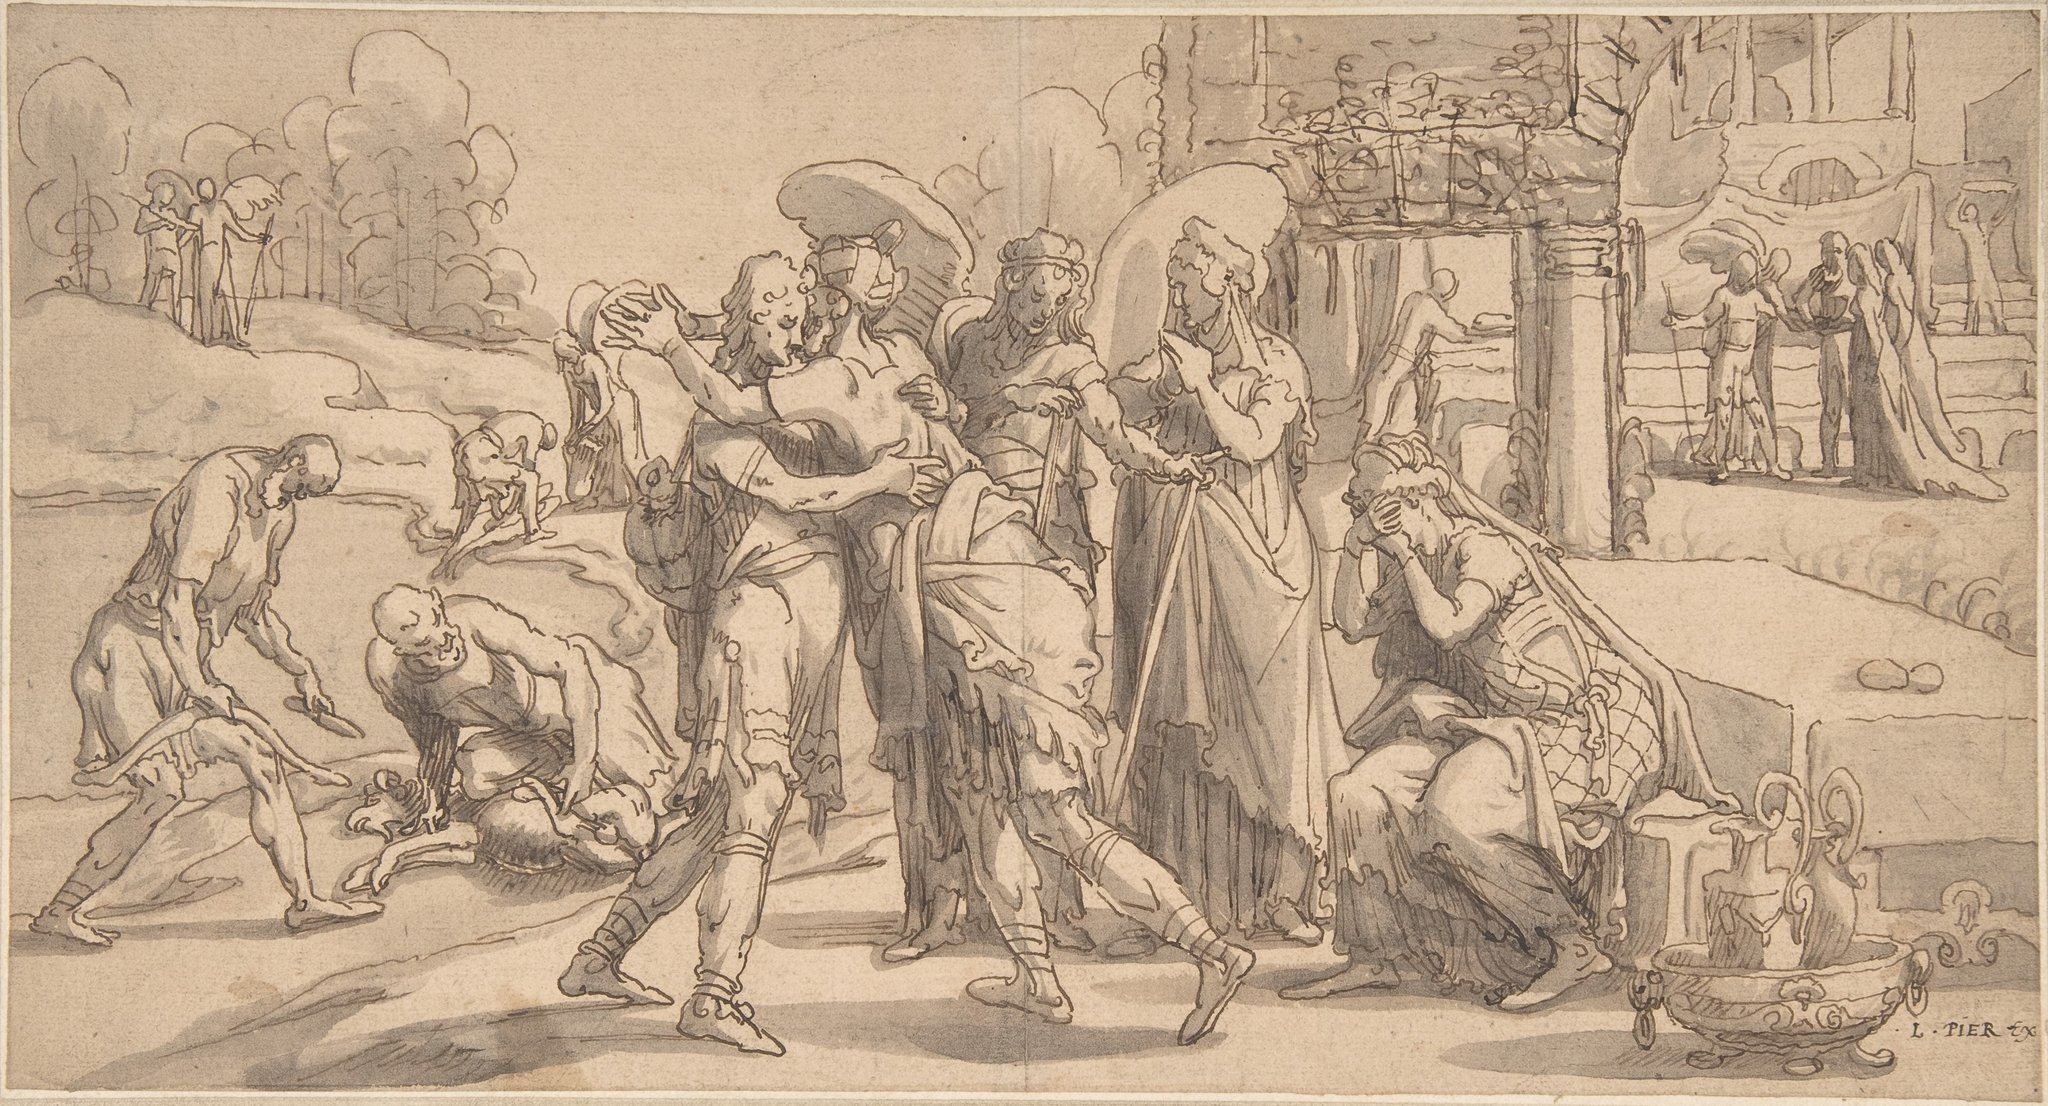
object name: drawing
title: Raguel's Reception of Tobias at Ecbatana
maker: pieter aertsen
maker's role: artist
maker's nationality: netherlandish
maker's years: 1507-1575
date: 1520-1575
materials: ink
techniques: pen, wash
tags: men,women